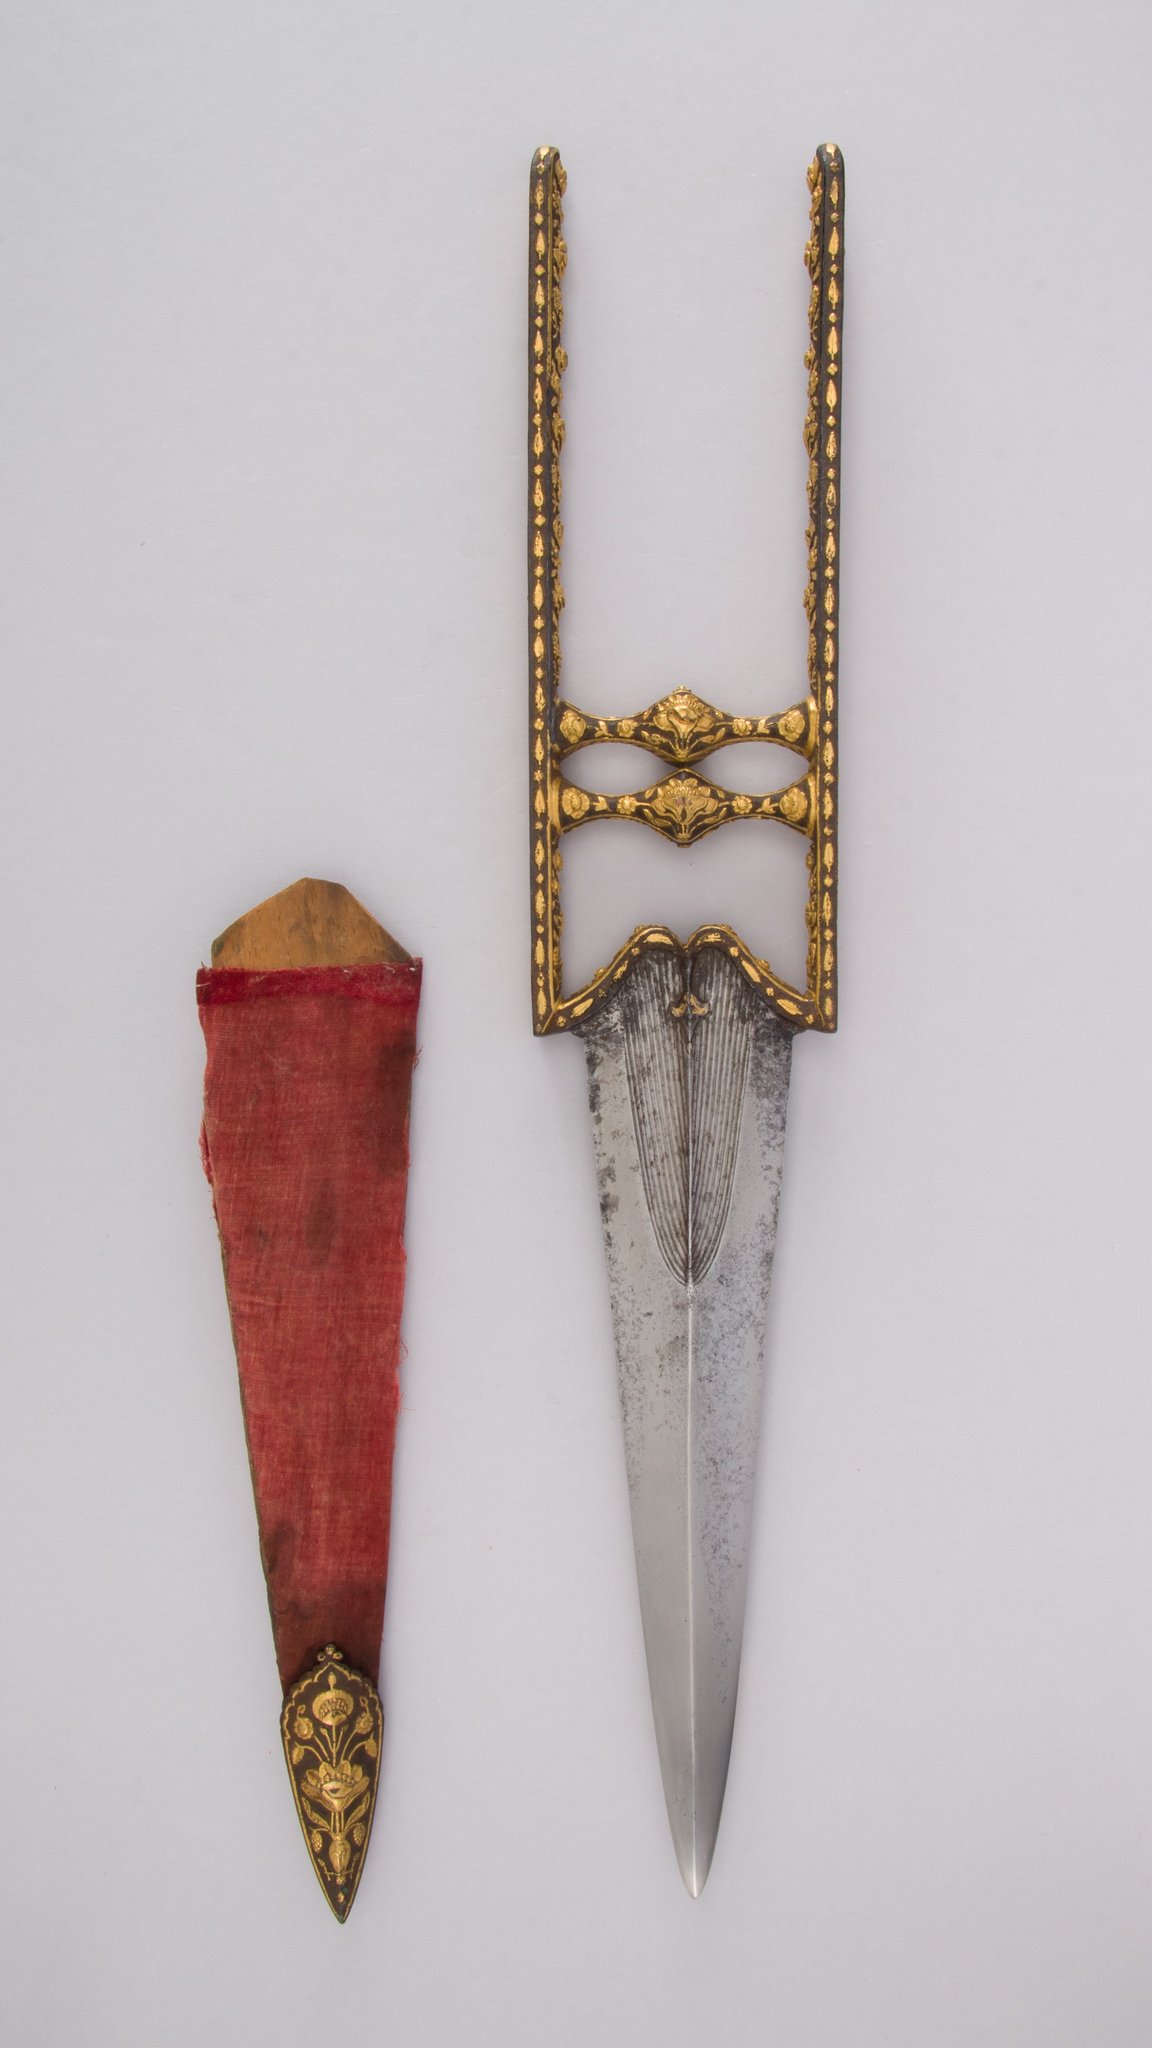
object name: dagger with sheath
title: Dagger (Katar) with Sheath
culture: indian, mughal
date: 1601-1700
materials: diamond, gold, iron, steel, velvet, wood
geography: india